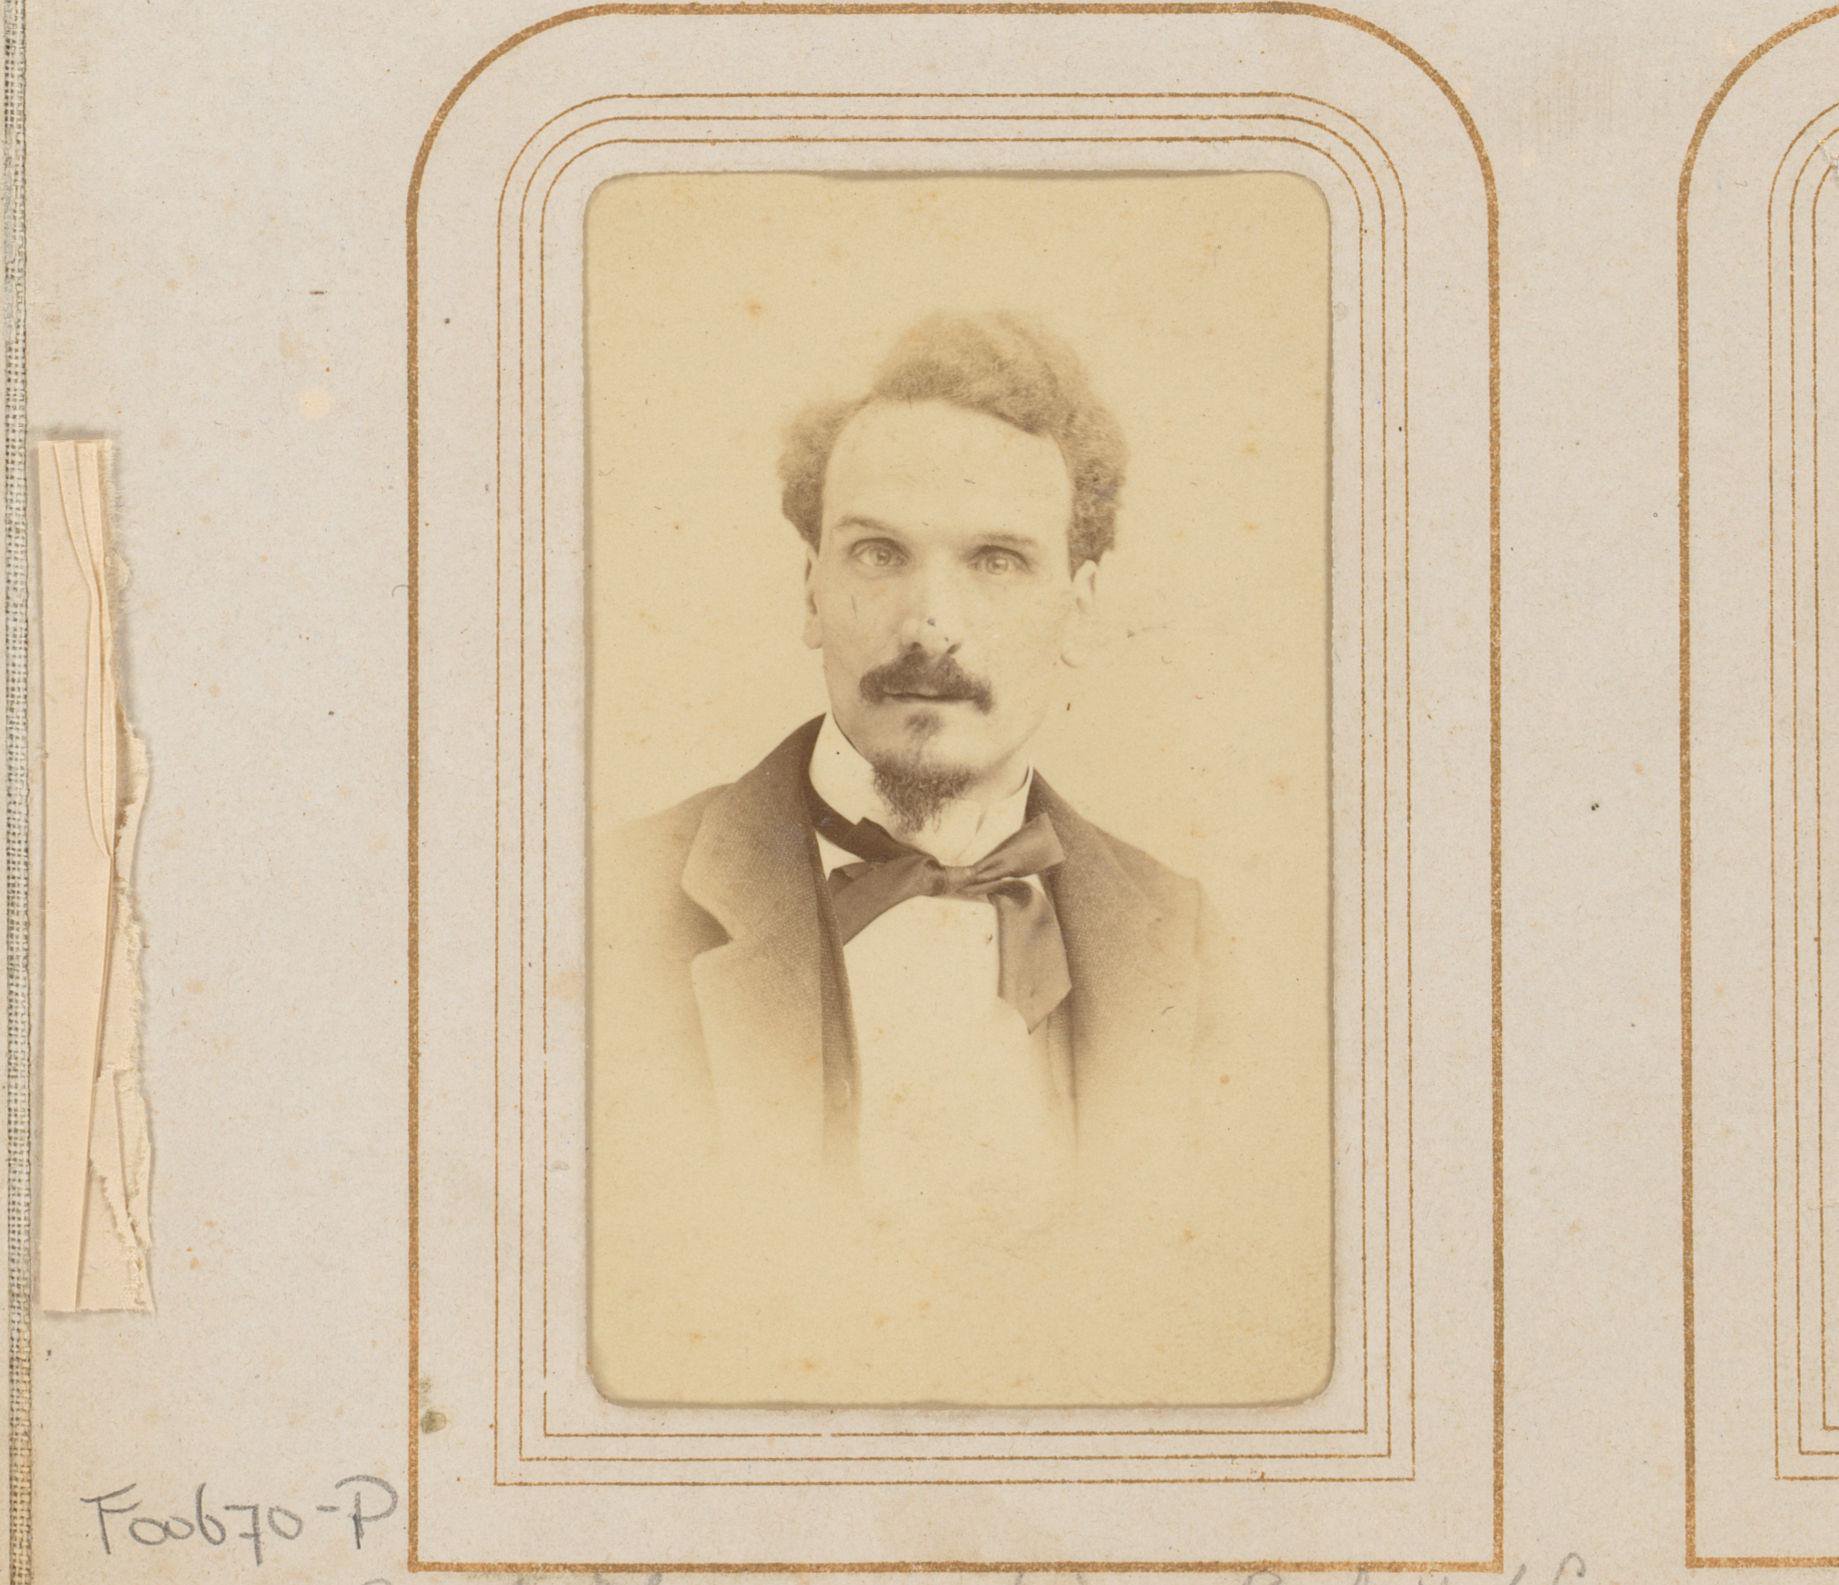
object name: photograph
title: Portret van Henri Rochefort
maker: andré-adolphe-eugène disdéri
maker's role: fotograaf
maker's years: 1819-1889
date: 1865-1870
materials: cardboard, photographic support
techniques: albumen print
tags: politician, journalist, reporter, historical persons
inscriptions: inscription: ‘Disdéri/ Paris, 8, Boulevard des Italiens (...)’, annotation: ‘Victor Henri, markies v Rochefort Luçay/ fr. journalist en politius -1913/ (Disdéri)’, name: ‘Rochefort’